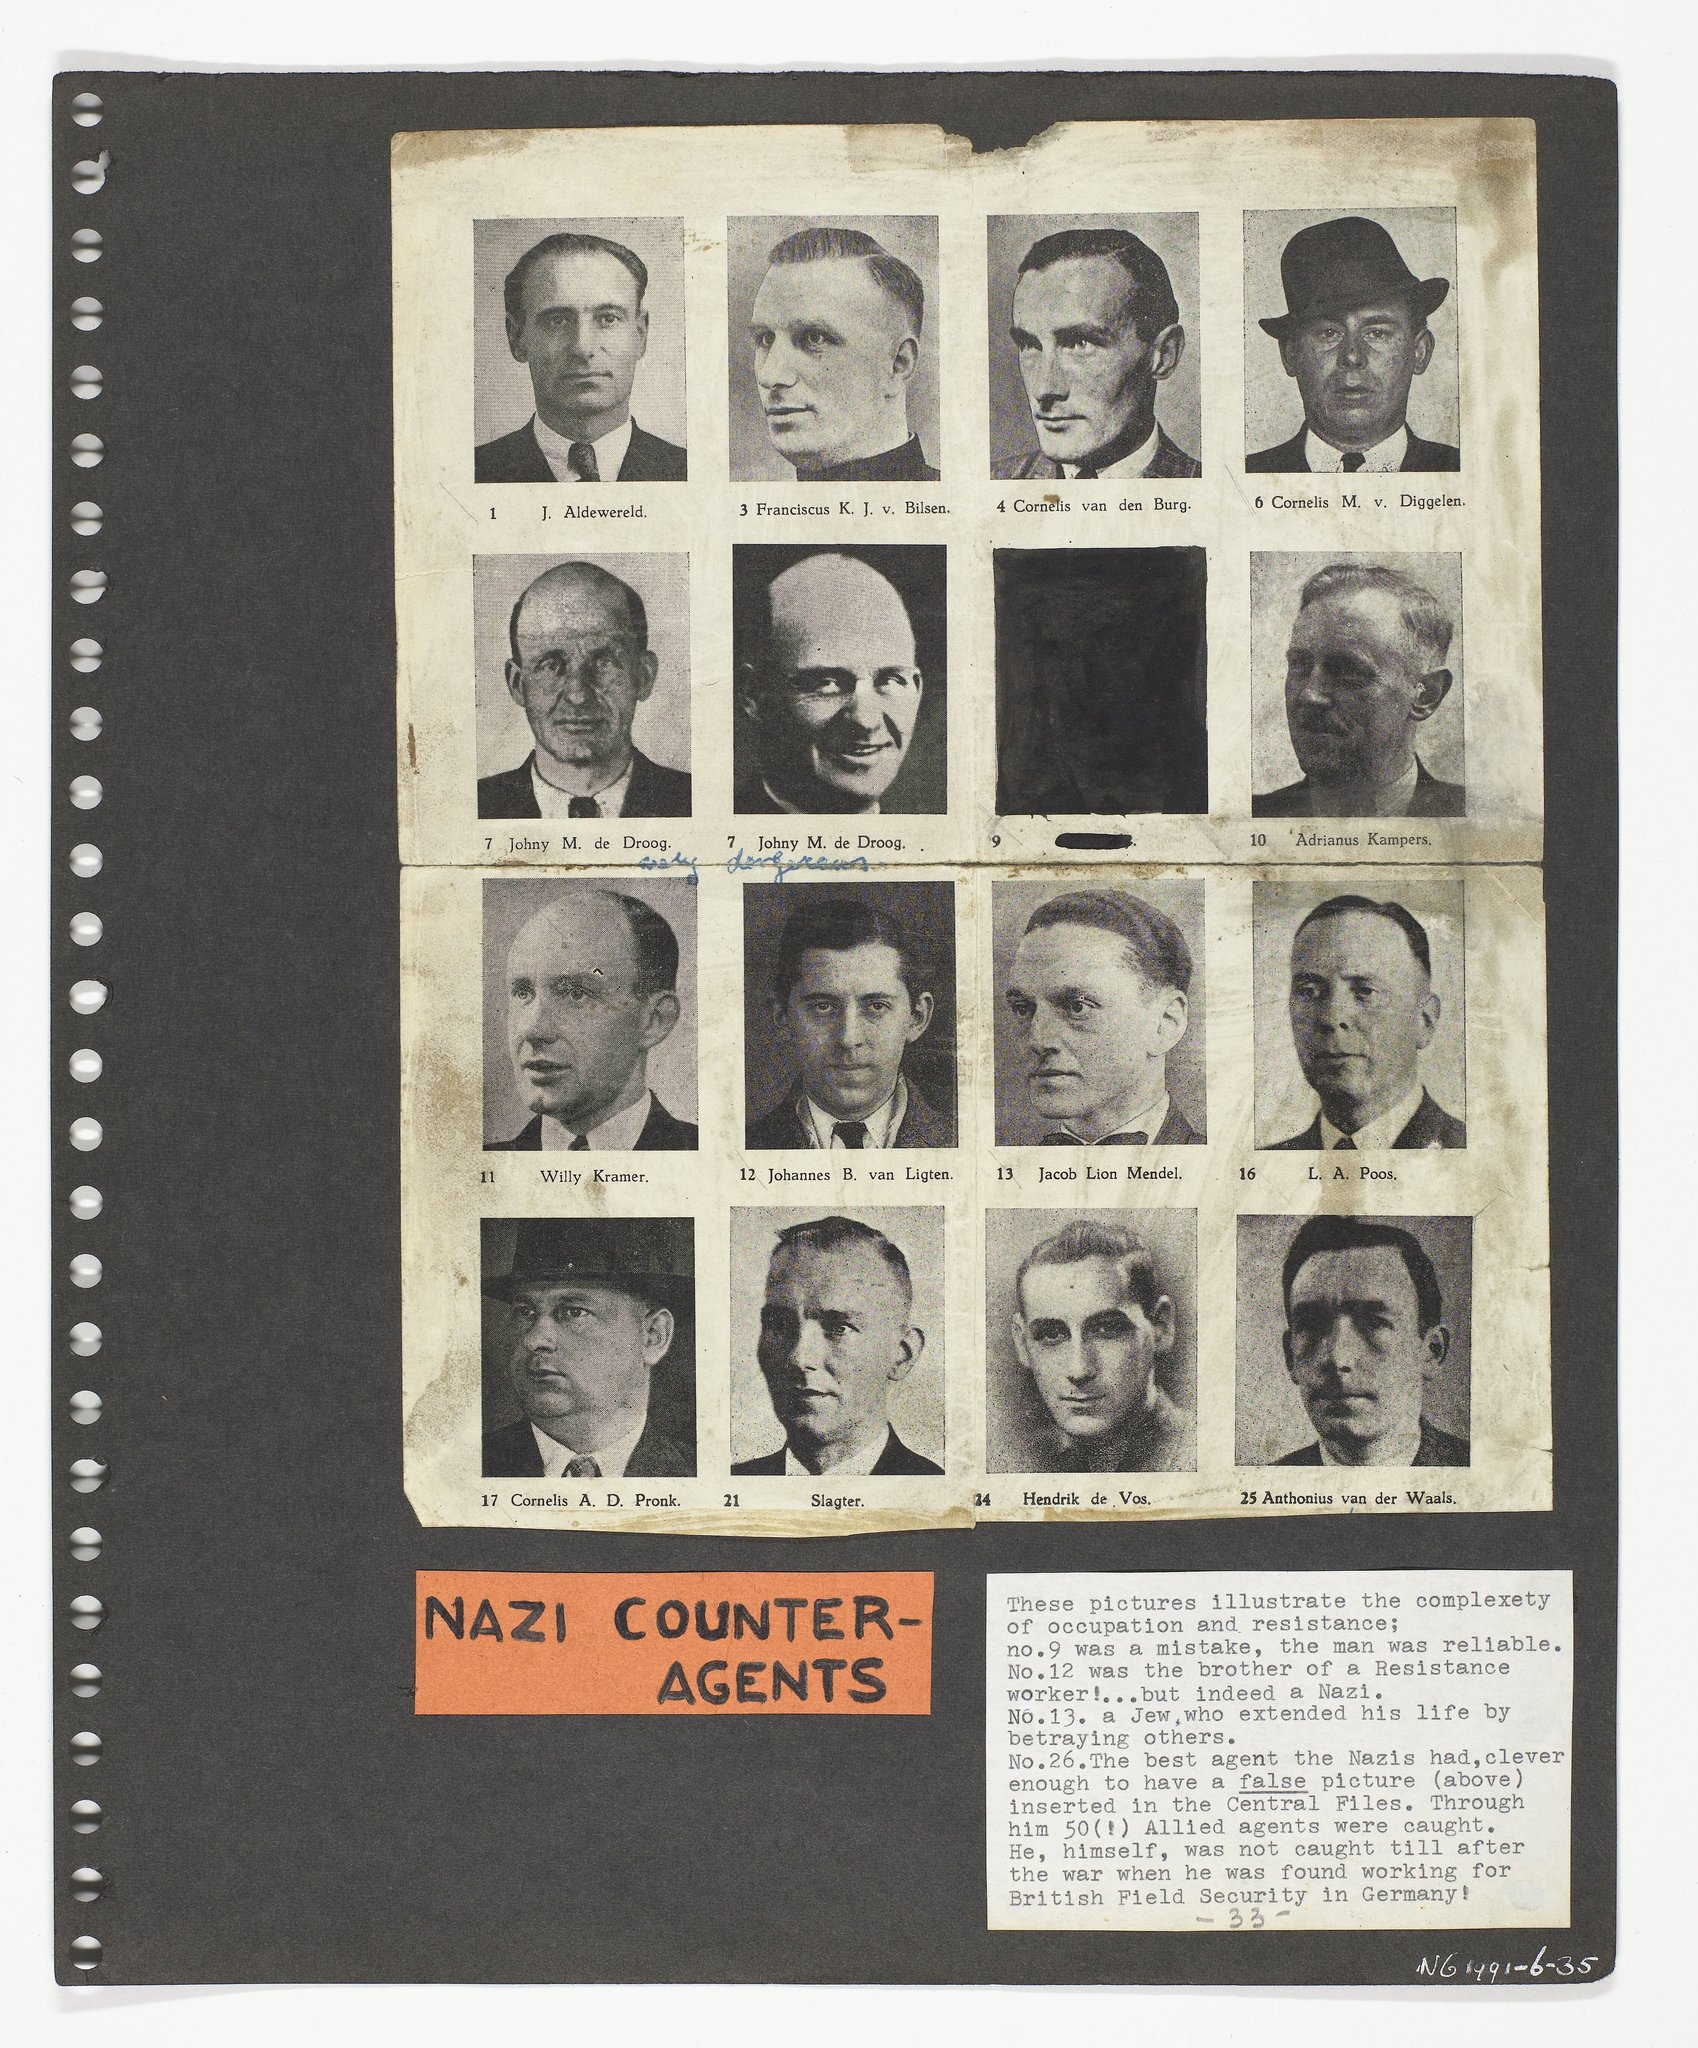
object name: album leaf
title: Foto en collageboek 'De Verborgen Camera'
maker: Anonymous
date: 1942-1945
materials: paper, plastic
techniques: photomechanical printing process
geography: netherlands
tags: amsterdam, tonny van renterghem, berlin, fritz kahlenberg, underground movement, partisans, historical persons, netherlands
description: Blad met portretten en namen van Nederlanders die trachtten verzetsgroepen te infiltreren en informatie doorspeelden aan de Duitsers.